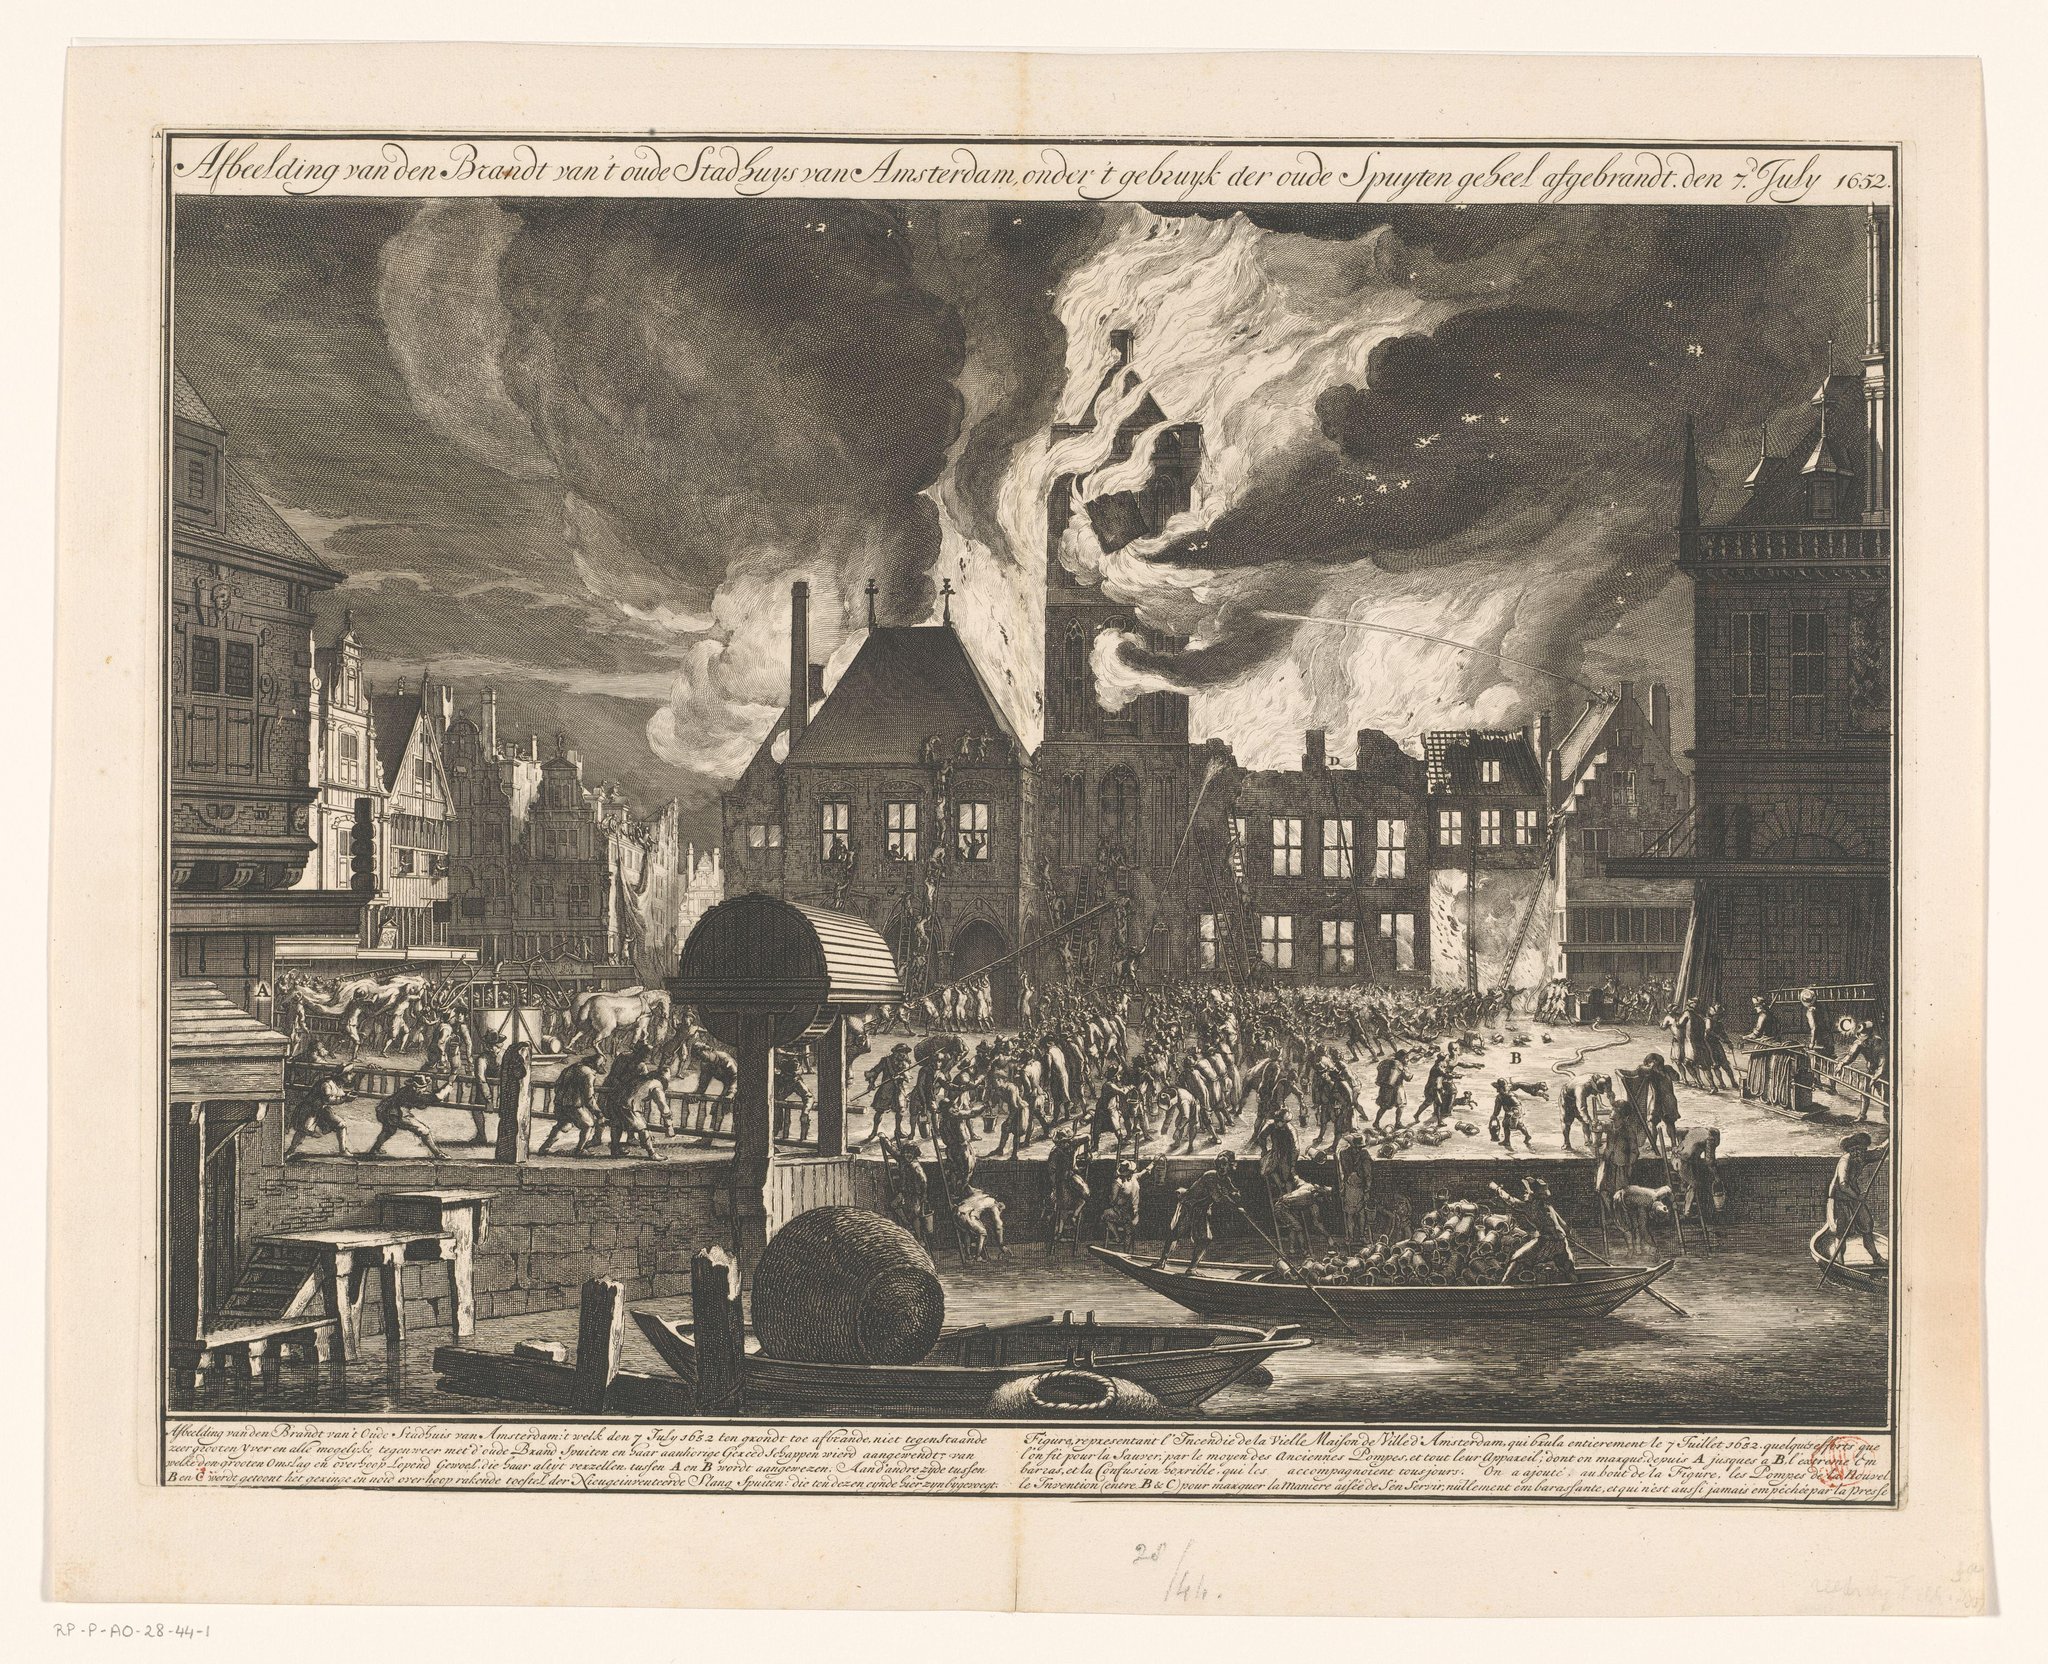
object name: book illustration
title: Afbeelding van den brandt van 't oude Stadhuys van Amsterdam, onder 't gebruyk der oude spuyten geheel afgebrandt. den 7. July 1652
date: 1690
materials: paper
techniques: engraving, etching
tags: amsterdam, painter, print maker, draughtsman, jan van der heyden, on fire, ablaze, townhall, fire-fighting, fire-extinguishing equipment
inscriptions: collector's mark: Lugt 195, collector's mark: Lugt 2228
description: Huidige staat van prent ook gebruikt in: Heyden, Jan van der. Beschryving der nieuwlyks uitgevonden en geoctrojeerde slang-brand-spuiten en haare wyze van brand-blussen, tegenwoordig binnen Amsterdam in gebruik zijnde (…). 2e druk. Amsterdam: erfgenamen Jan van der Heyden, 1735. Tweede bekende staat van prent ook gebruikt in: Heyden, Jan van der. Beschryving der nieuwlyks uitgevonden en geoctrojeerde slang-brand-spuiten en haare wyze van brand-blussen, tegenwoordig binnen Amsterdam in gebruik zijnde (…). 1e druk. Amsterdam: Jan Rieuwertsz. (II), 1690. Voor eerste bekende staat zie RP-P-AO-28-44-2 en RP-P-OB-55.389. Voor tweede bekende staat zie RP-P-OB-81.741 en RP-P-OB-82.081. Voor derde bekende staat zie RP-P-AO-28-44-1 en RP-P-OB-81.742.